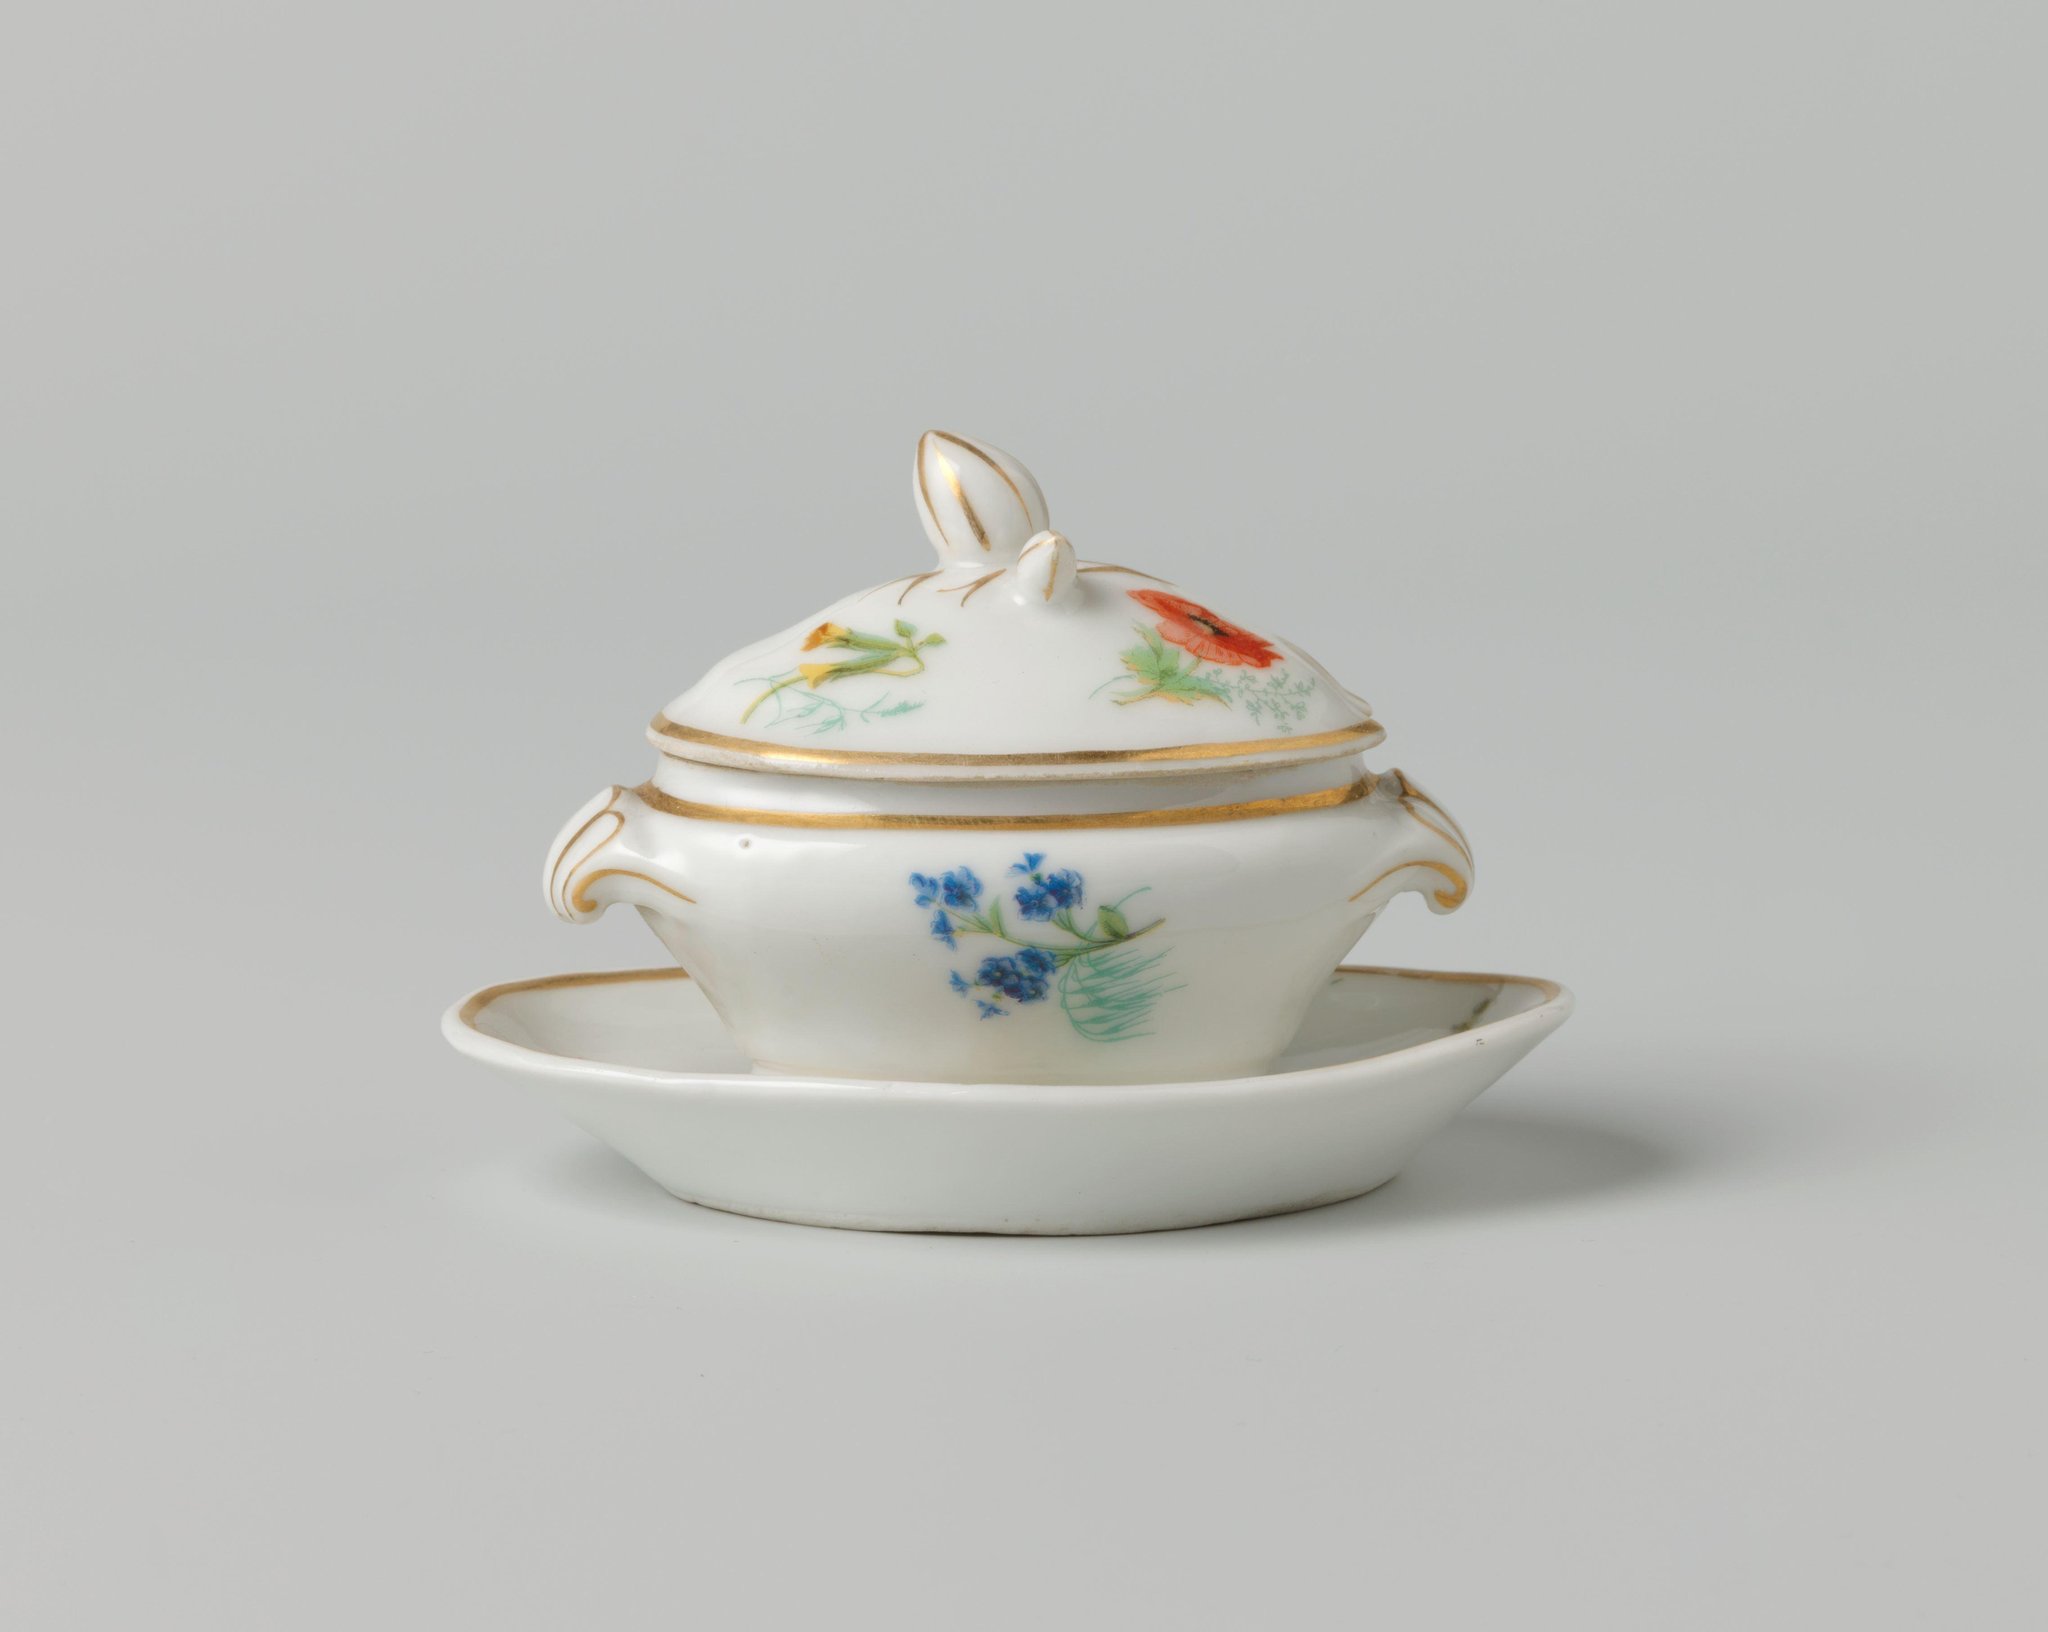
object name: kinderservies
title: Cover of a tureen with various flower sprays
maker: Anonymous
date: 1850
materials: glaze, gold, paint, porcelain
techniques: firing, forming, gilding, turning, vitrification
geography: france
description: Deksel van een terrine van porselein, versierd op het glazuur met blauw, rood, roze, groen, geel, paars en goud. Met verschillende bloemtakken en gouden lijnen op de rand en knop. Dekselknop in de vorm van een bloemtak met twee knoppen op een gemodelleerd blad.